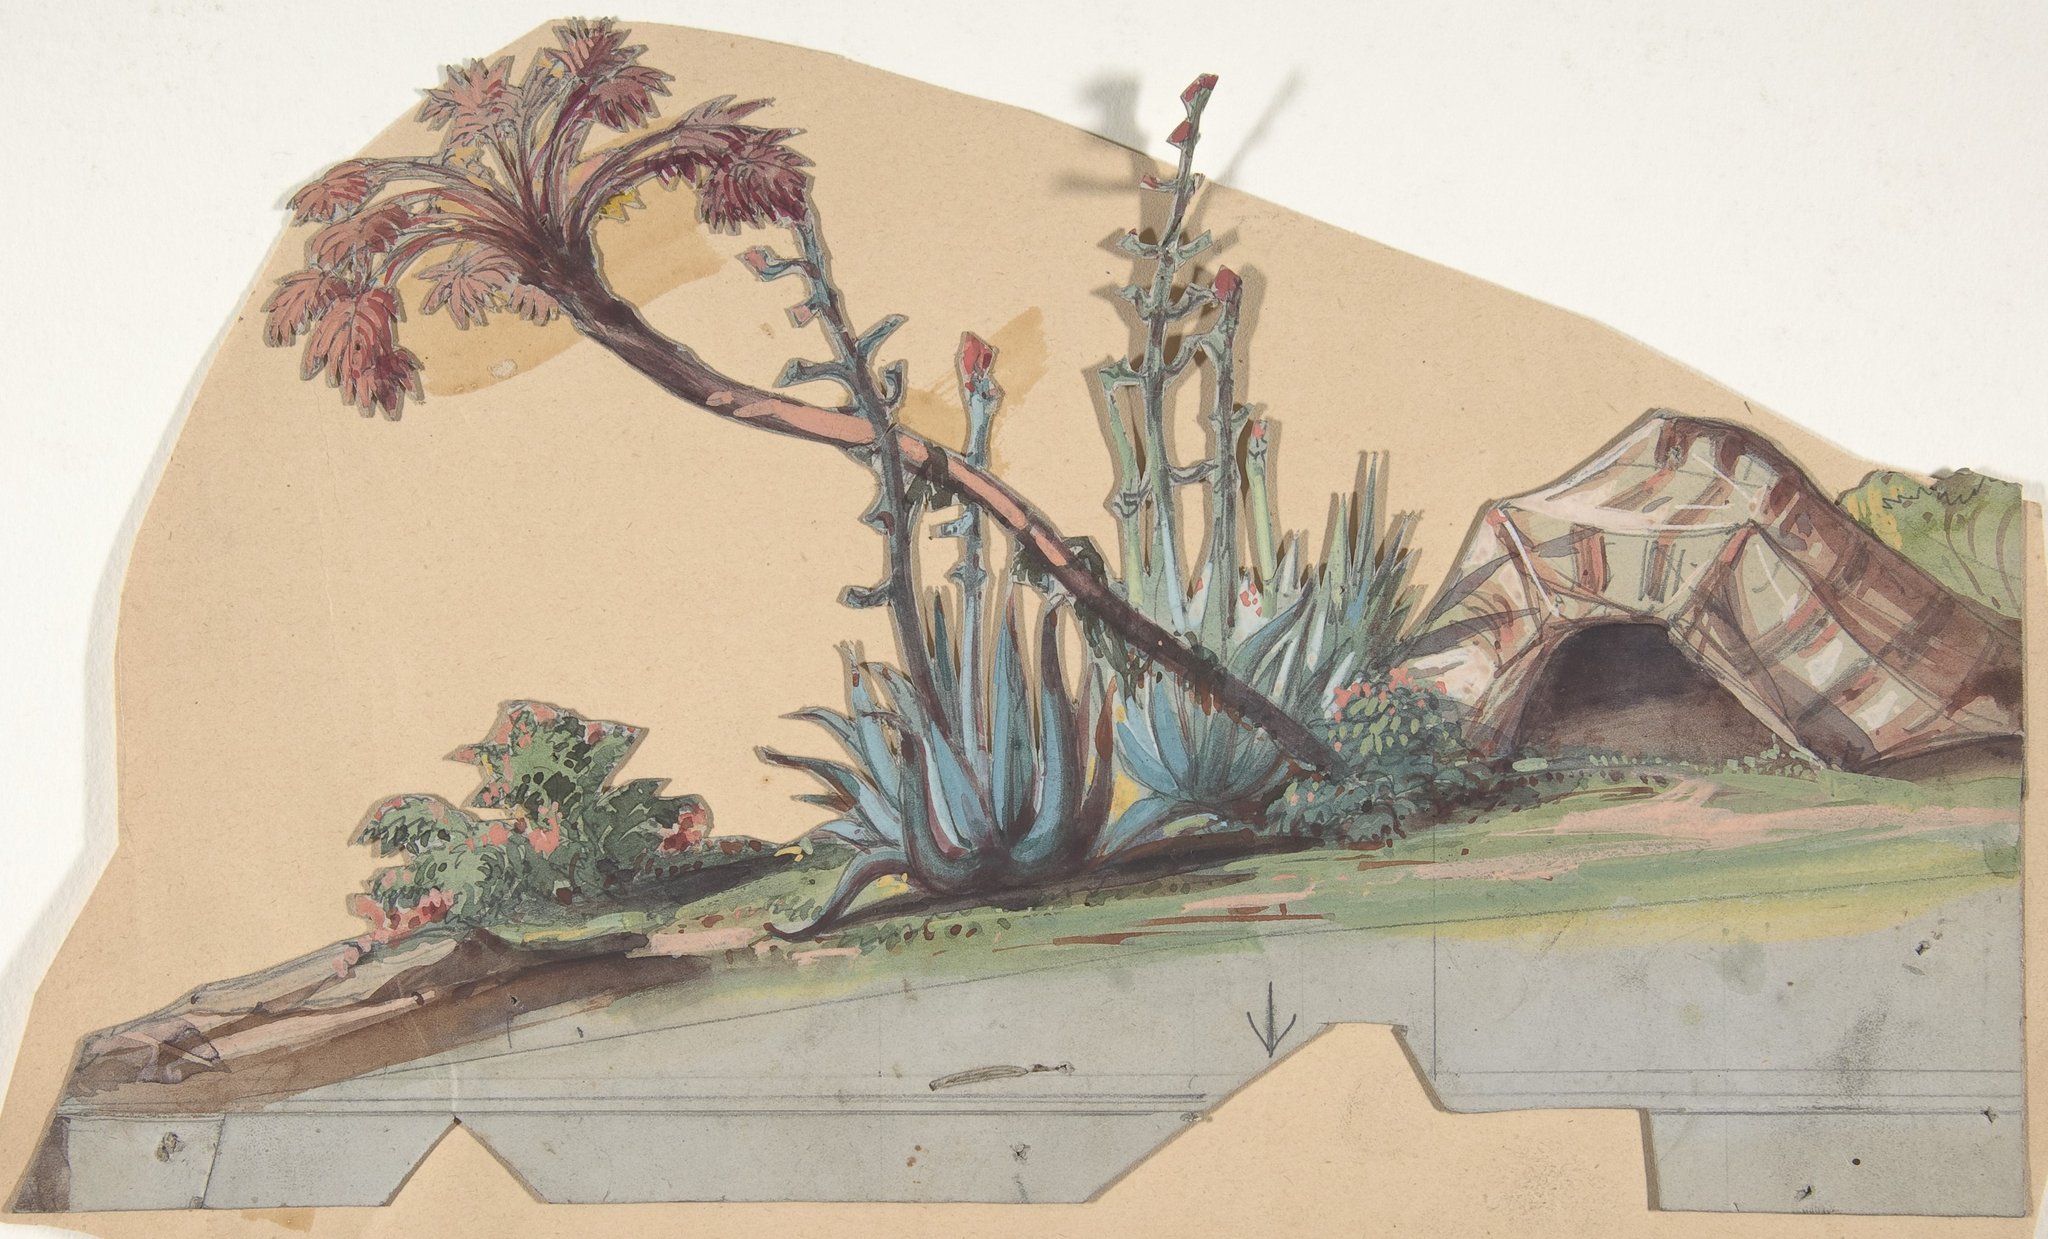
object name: drawing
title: Design for a Stage Set at the Opéra, Paris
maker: eugène cicéri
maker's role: artist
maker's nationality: french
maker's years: 1813-1890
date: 1830-1890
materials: gouache, graphite, watercolor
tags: tents,trees,stage design